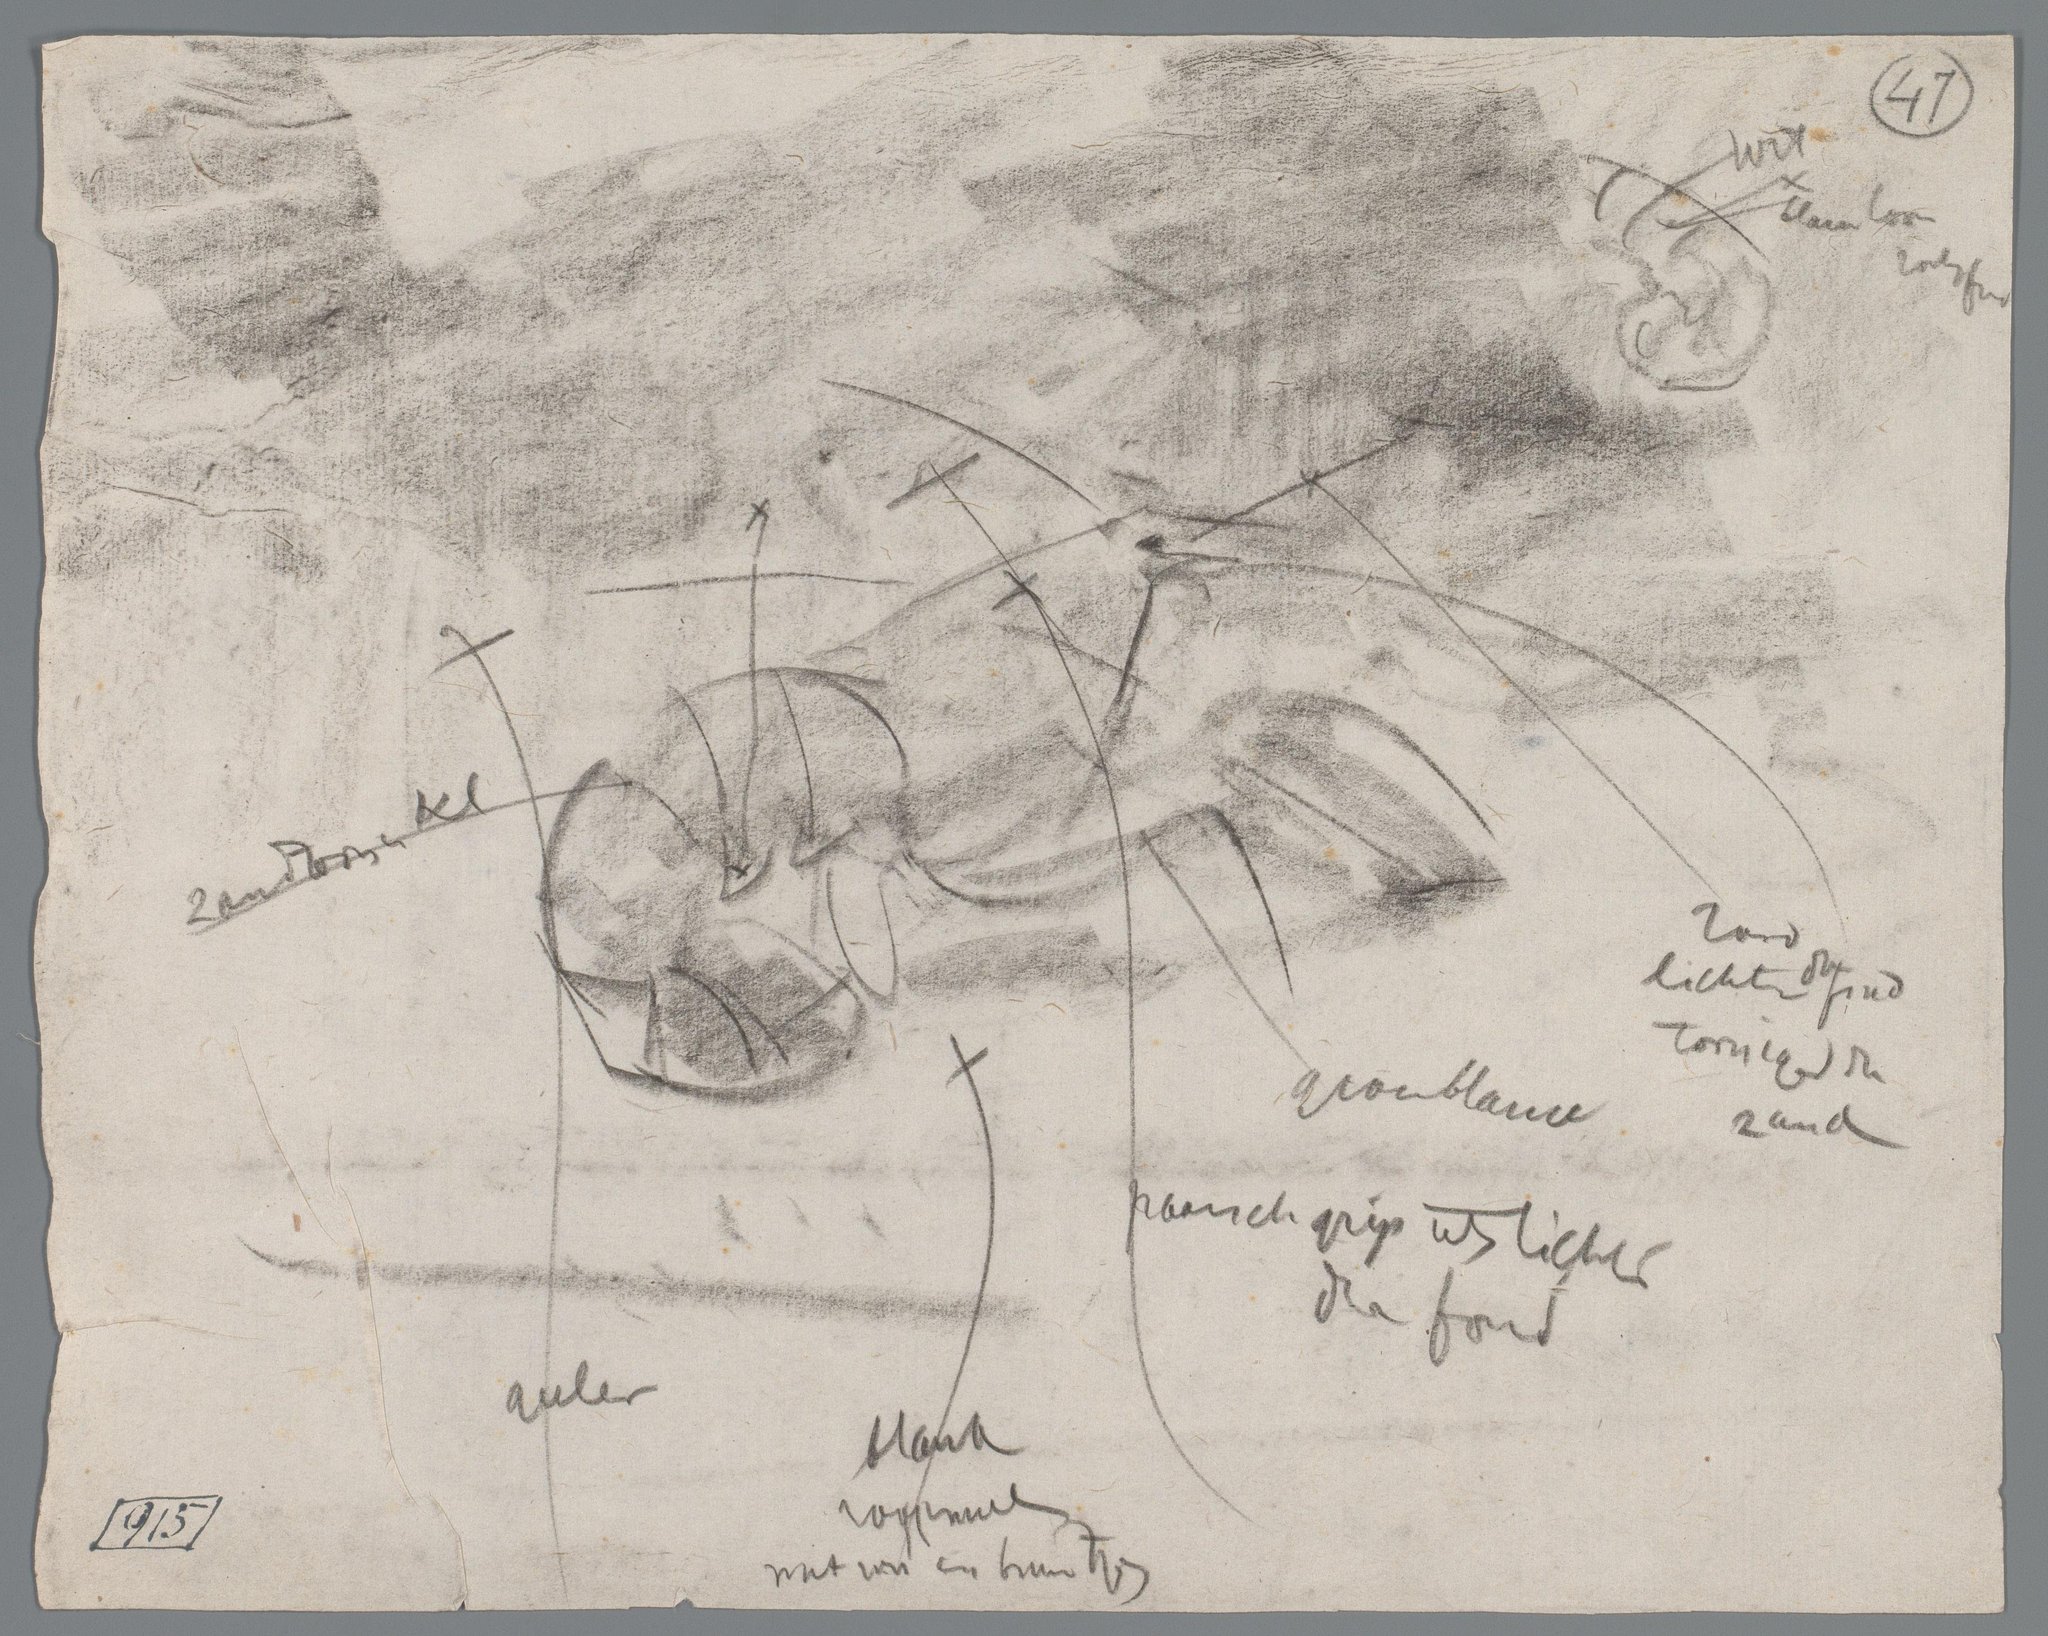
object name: drawing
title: Studie van een kreeft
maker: gerrit willem dijsselhof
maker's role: designer, draughtsman, print maker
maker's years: 1866-1924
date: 1876-1924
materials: chalk, paper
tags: crustaceans: lobster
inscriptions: number: ‘47’, number: ‘915’